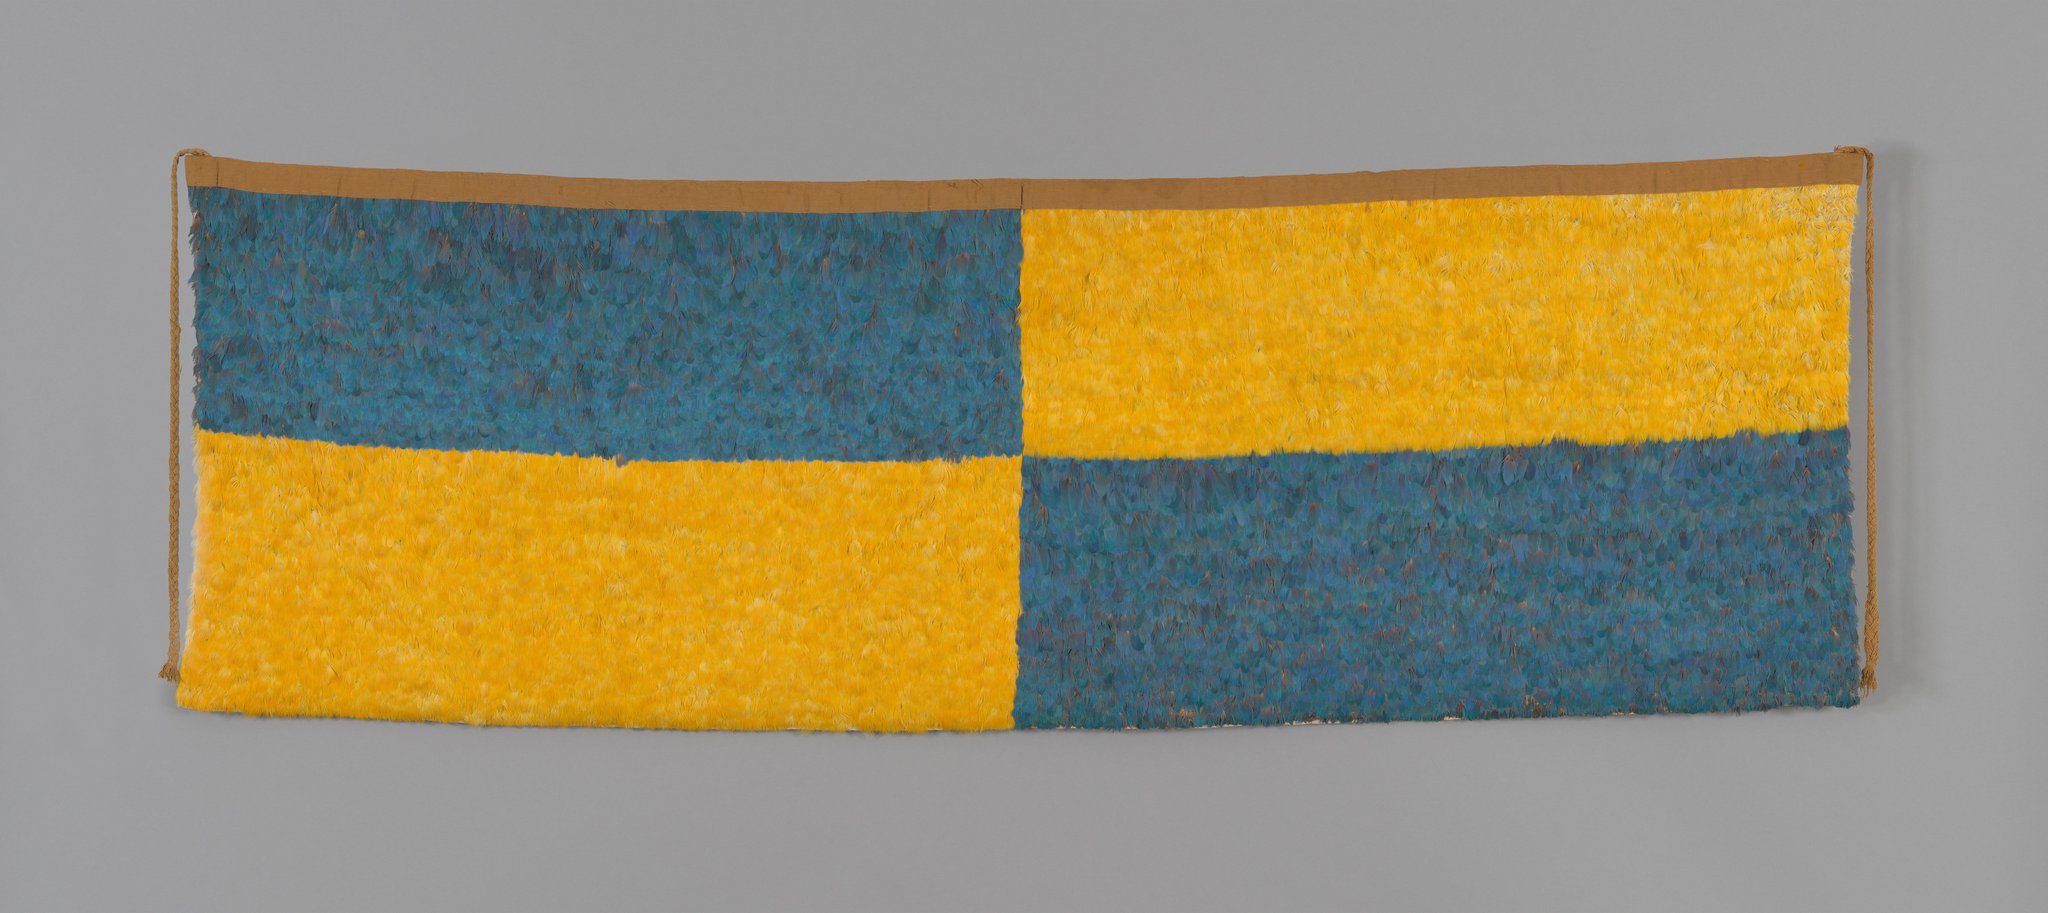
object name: panel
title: Feathered panel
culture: wari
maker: wari artist(s)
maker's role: artist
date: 650-1000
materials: animal fiber, cotton, feather, fiber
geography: peru